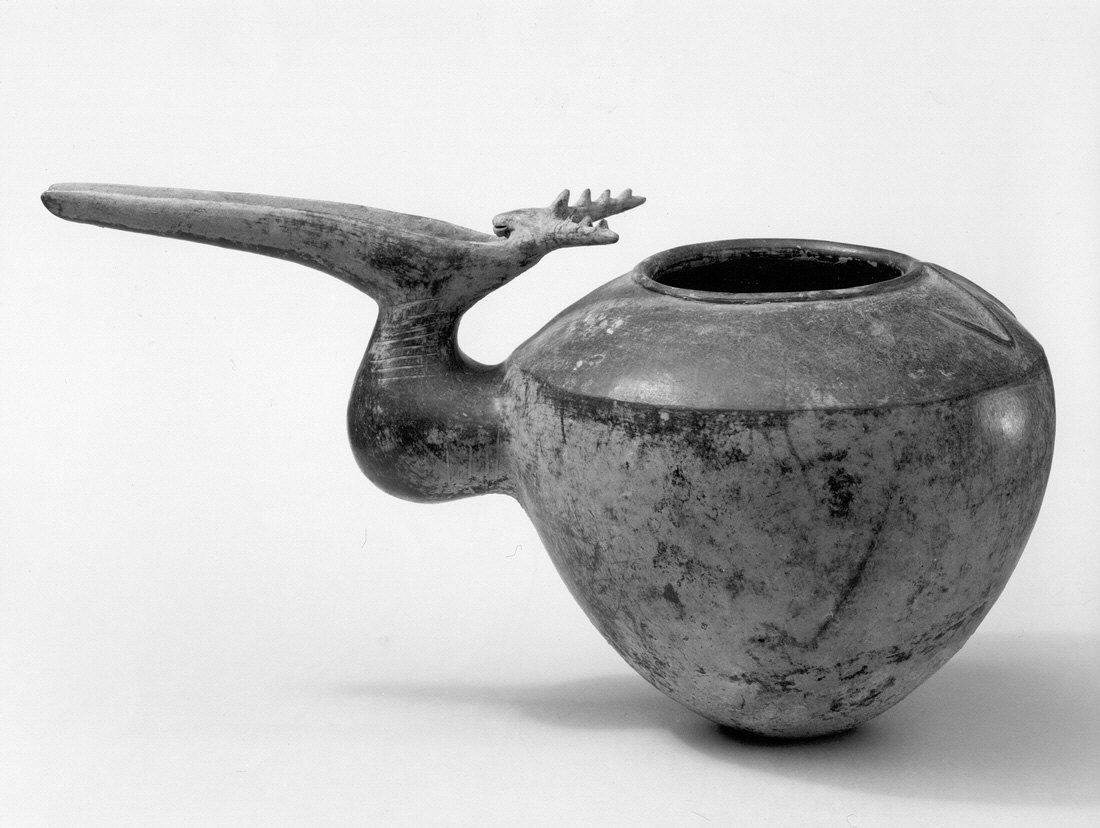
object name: vessel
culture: iranian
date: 1000 BCE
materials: ceramic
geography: iran